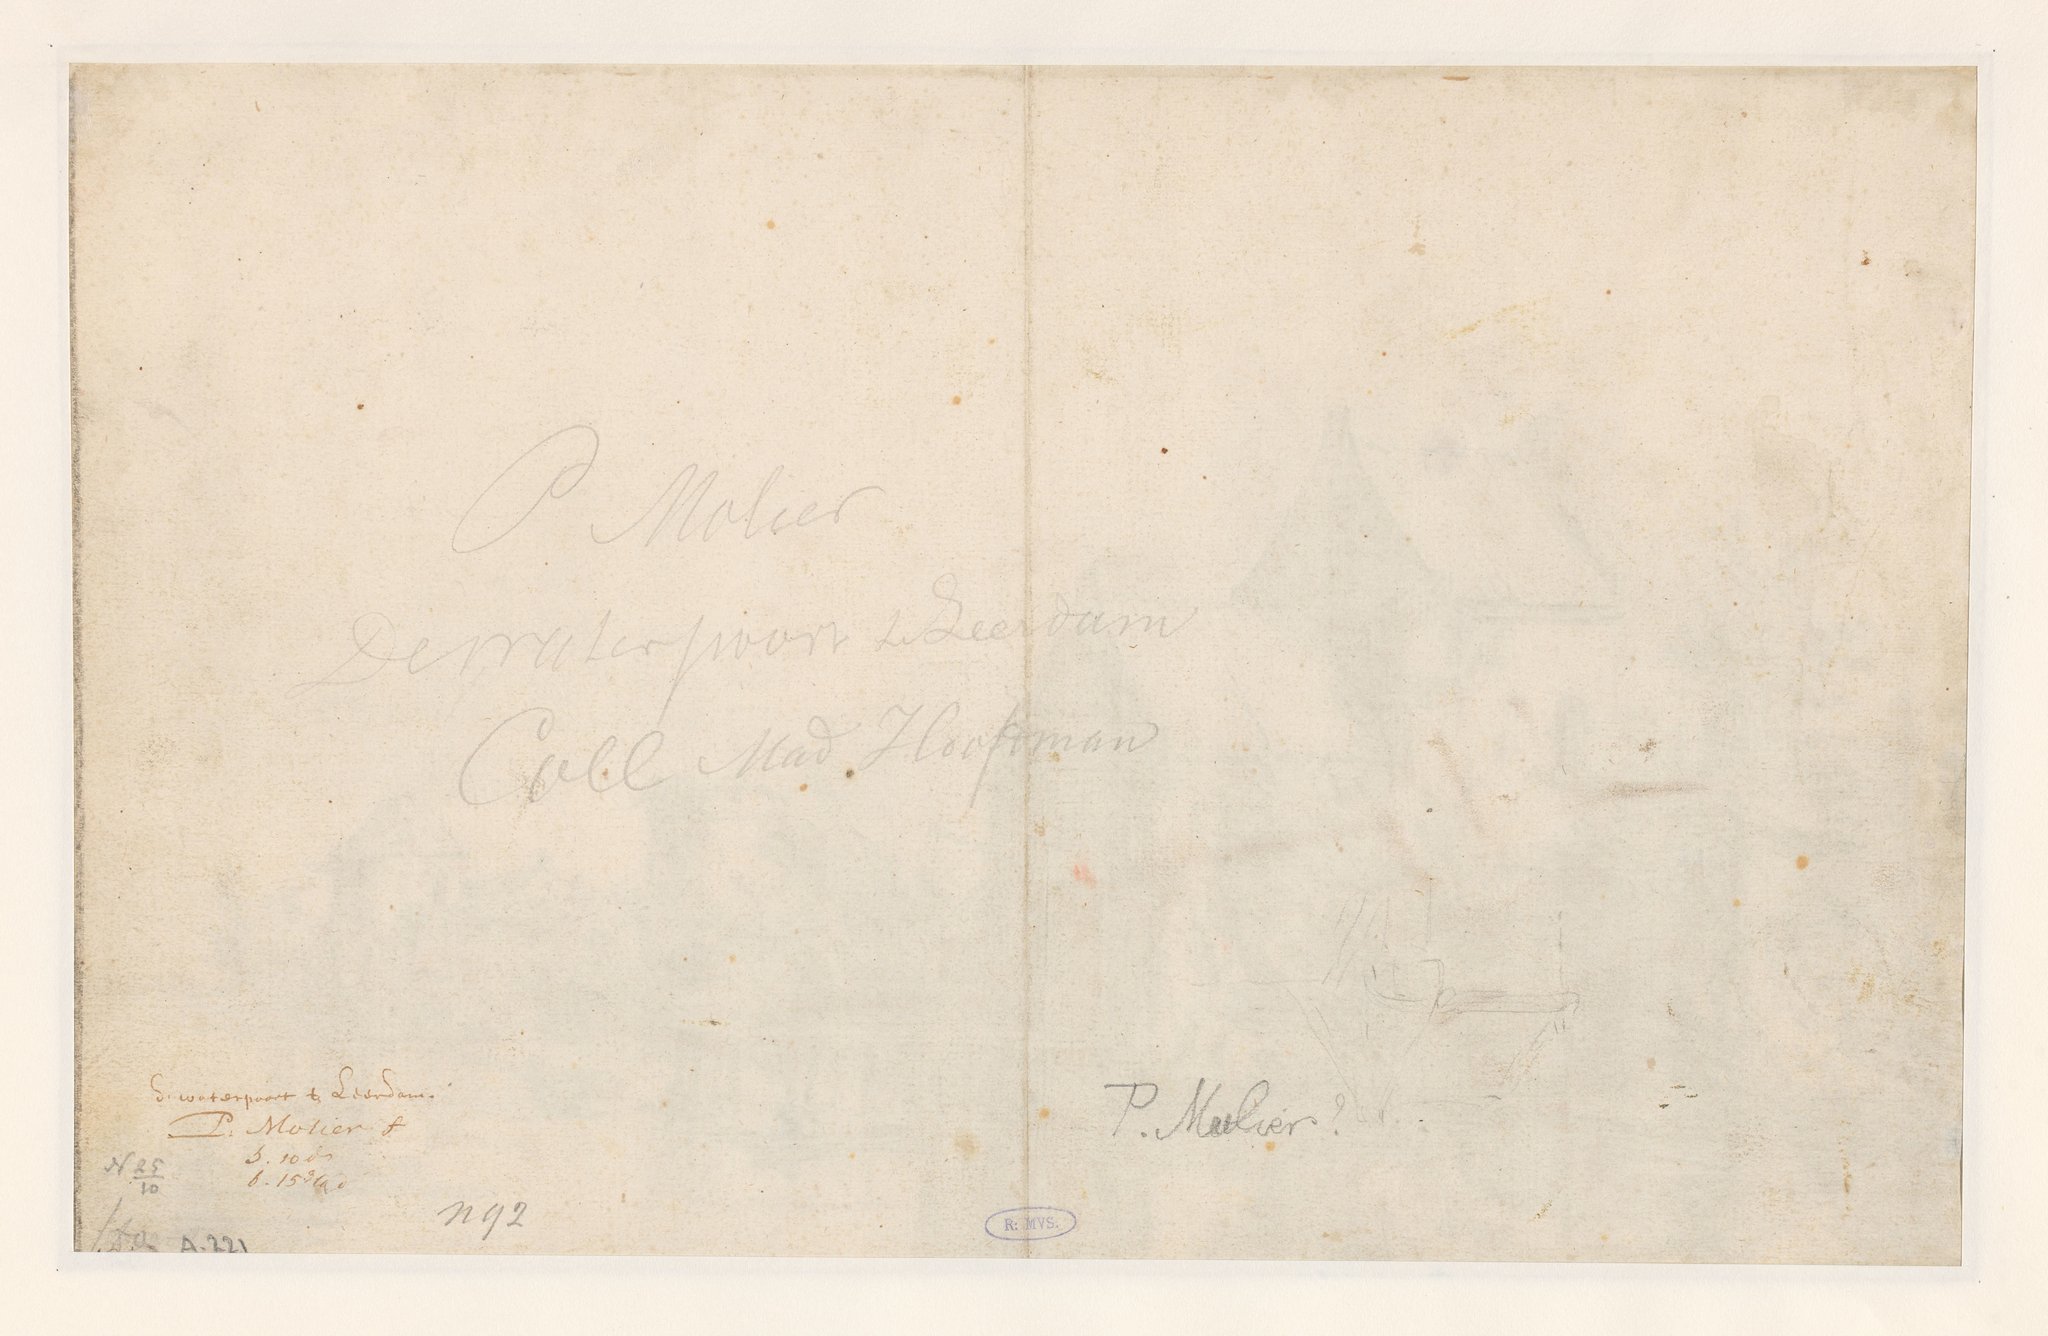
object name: drawing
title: Sketch of the Heeswijkerpoort/ recto: View of the Heeswijkerpoort, Montfoort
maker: pieter mulier (ii)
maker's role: draughtsman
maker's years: 1637-1701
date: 1654-1655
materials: chalk, paper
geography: montfoort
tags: city-gate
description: Gezicht op de stadswal en de Heeswijkerpoort in Montfoort